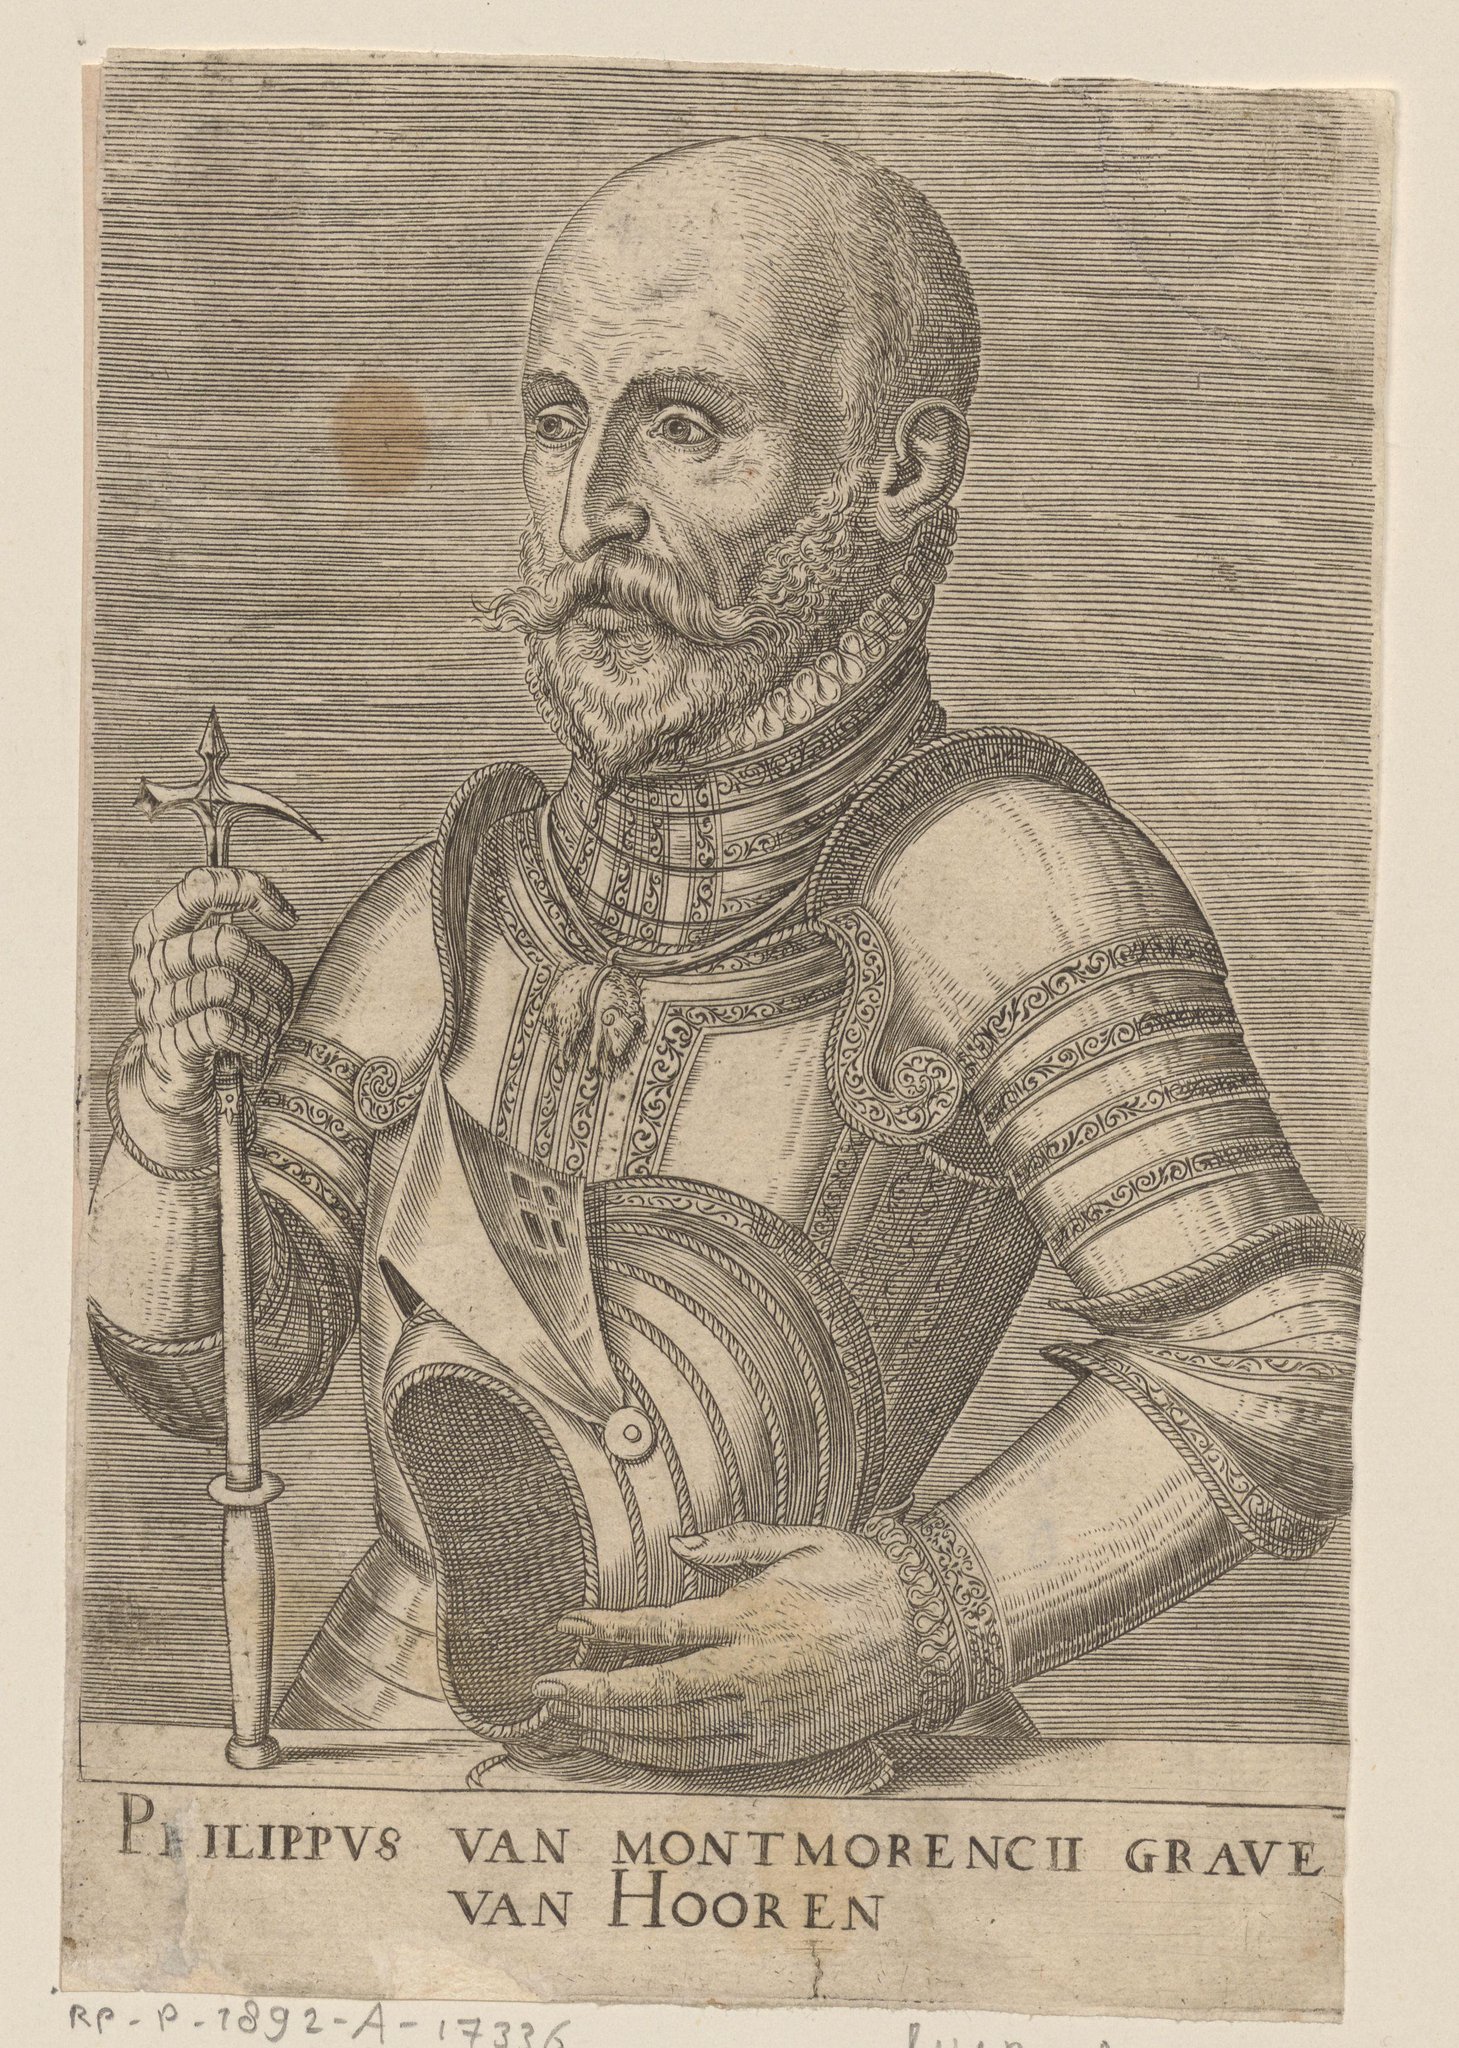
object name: print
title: Portret van Filips van Montmorency, graaf van Horne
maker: Anonymous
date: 1590-1630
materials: paper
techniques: engraving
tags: brussels, helmet, armour, historical persons, knighthood order of the golden fleece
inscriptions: collector's mark: Lugt 2228